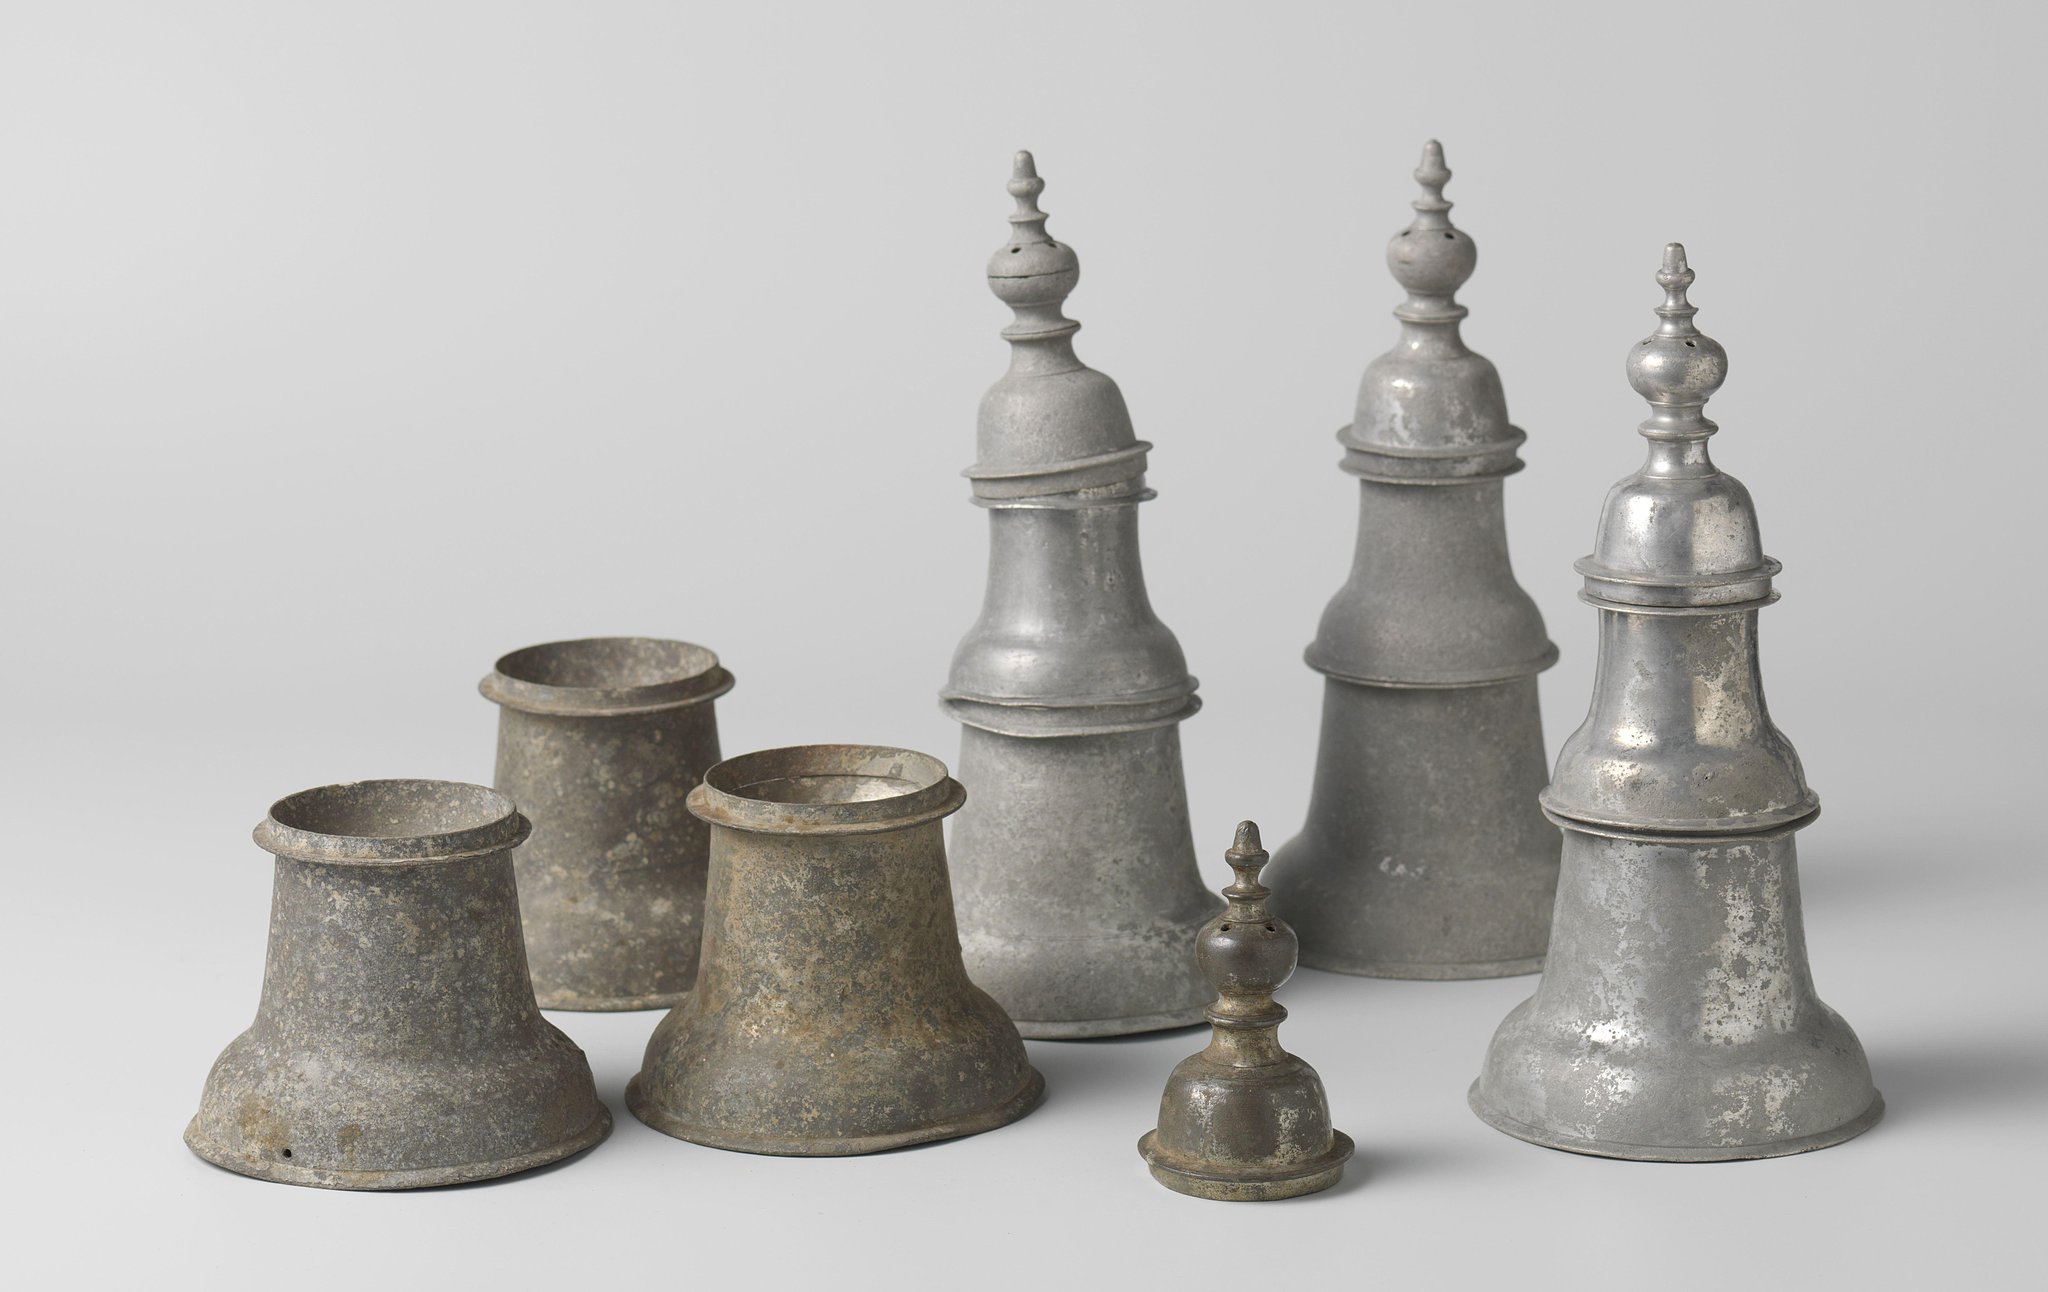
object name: salt condiment vessel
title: Zoutvat met deksel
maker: Anonymous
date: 1590-1596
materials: tin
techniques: casting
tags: willem barendsz., amsterdam, jacob van heemskerck